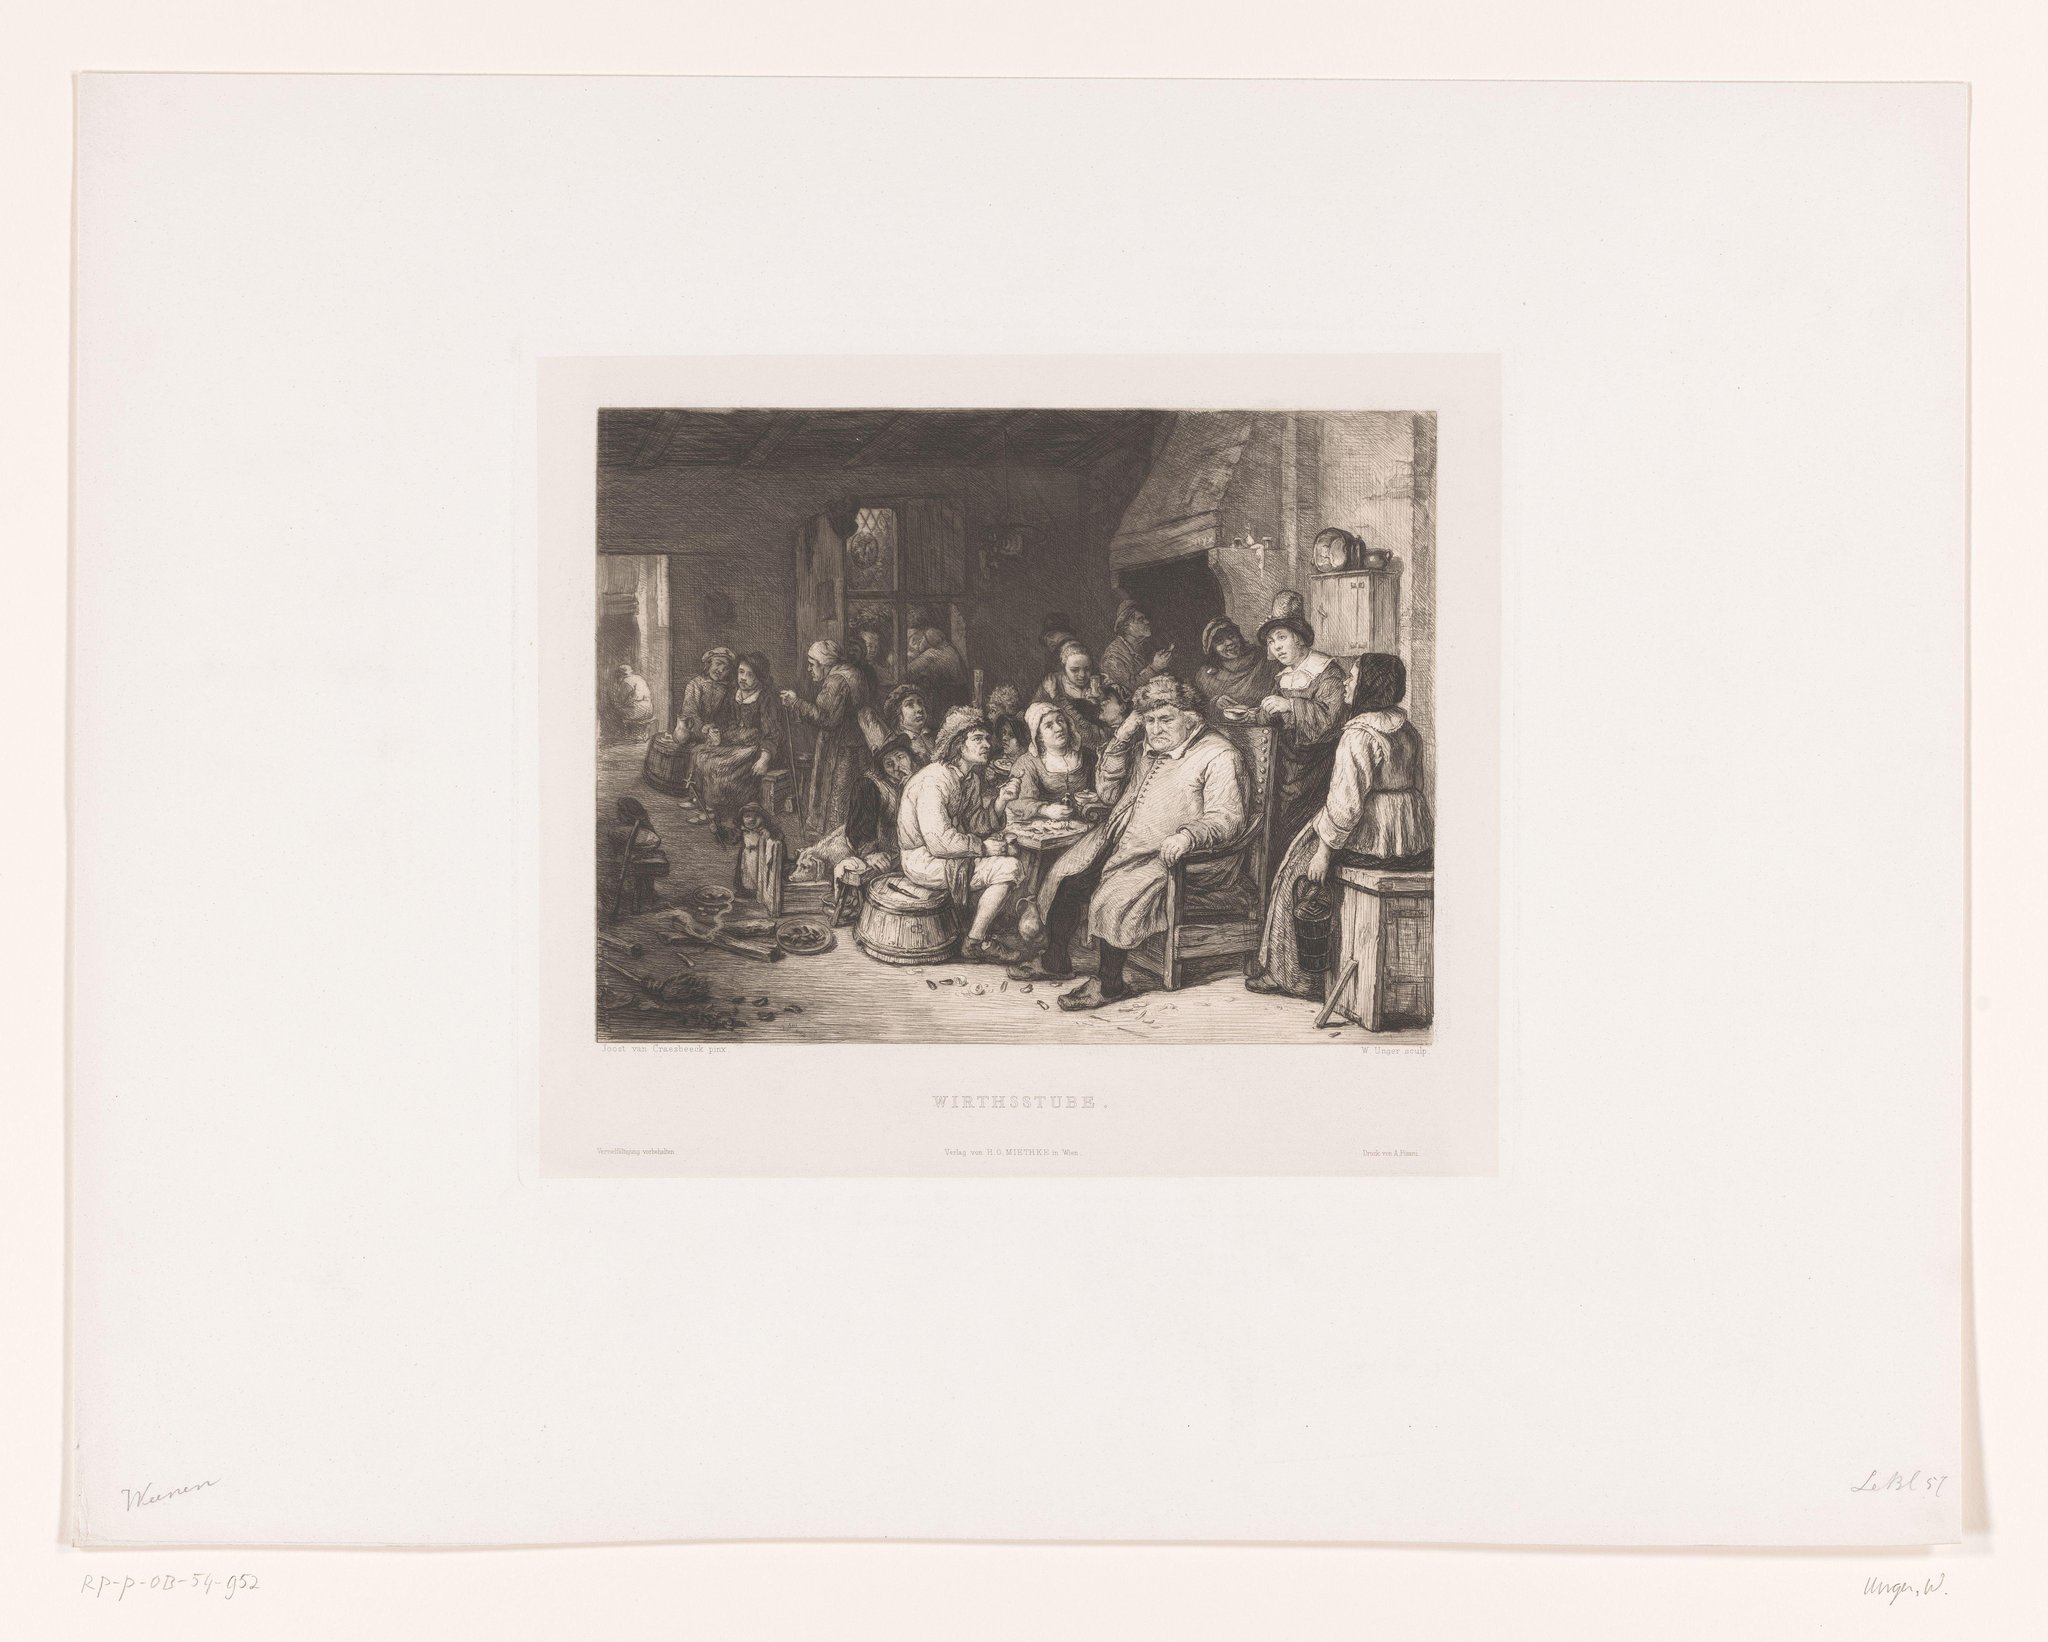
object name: print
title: Wirthsstube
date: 1861-1932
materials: paper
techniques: etching, intaglio, roulette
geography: germany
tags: pipe ~ tobacco, alcoholic drinks, hotel, hostelry, inn